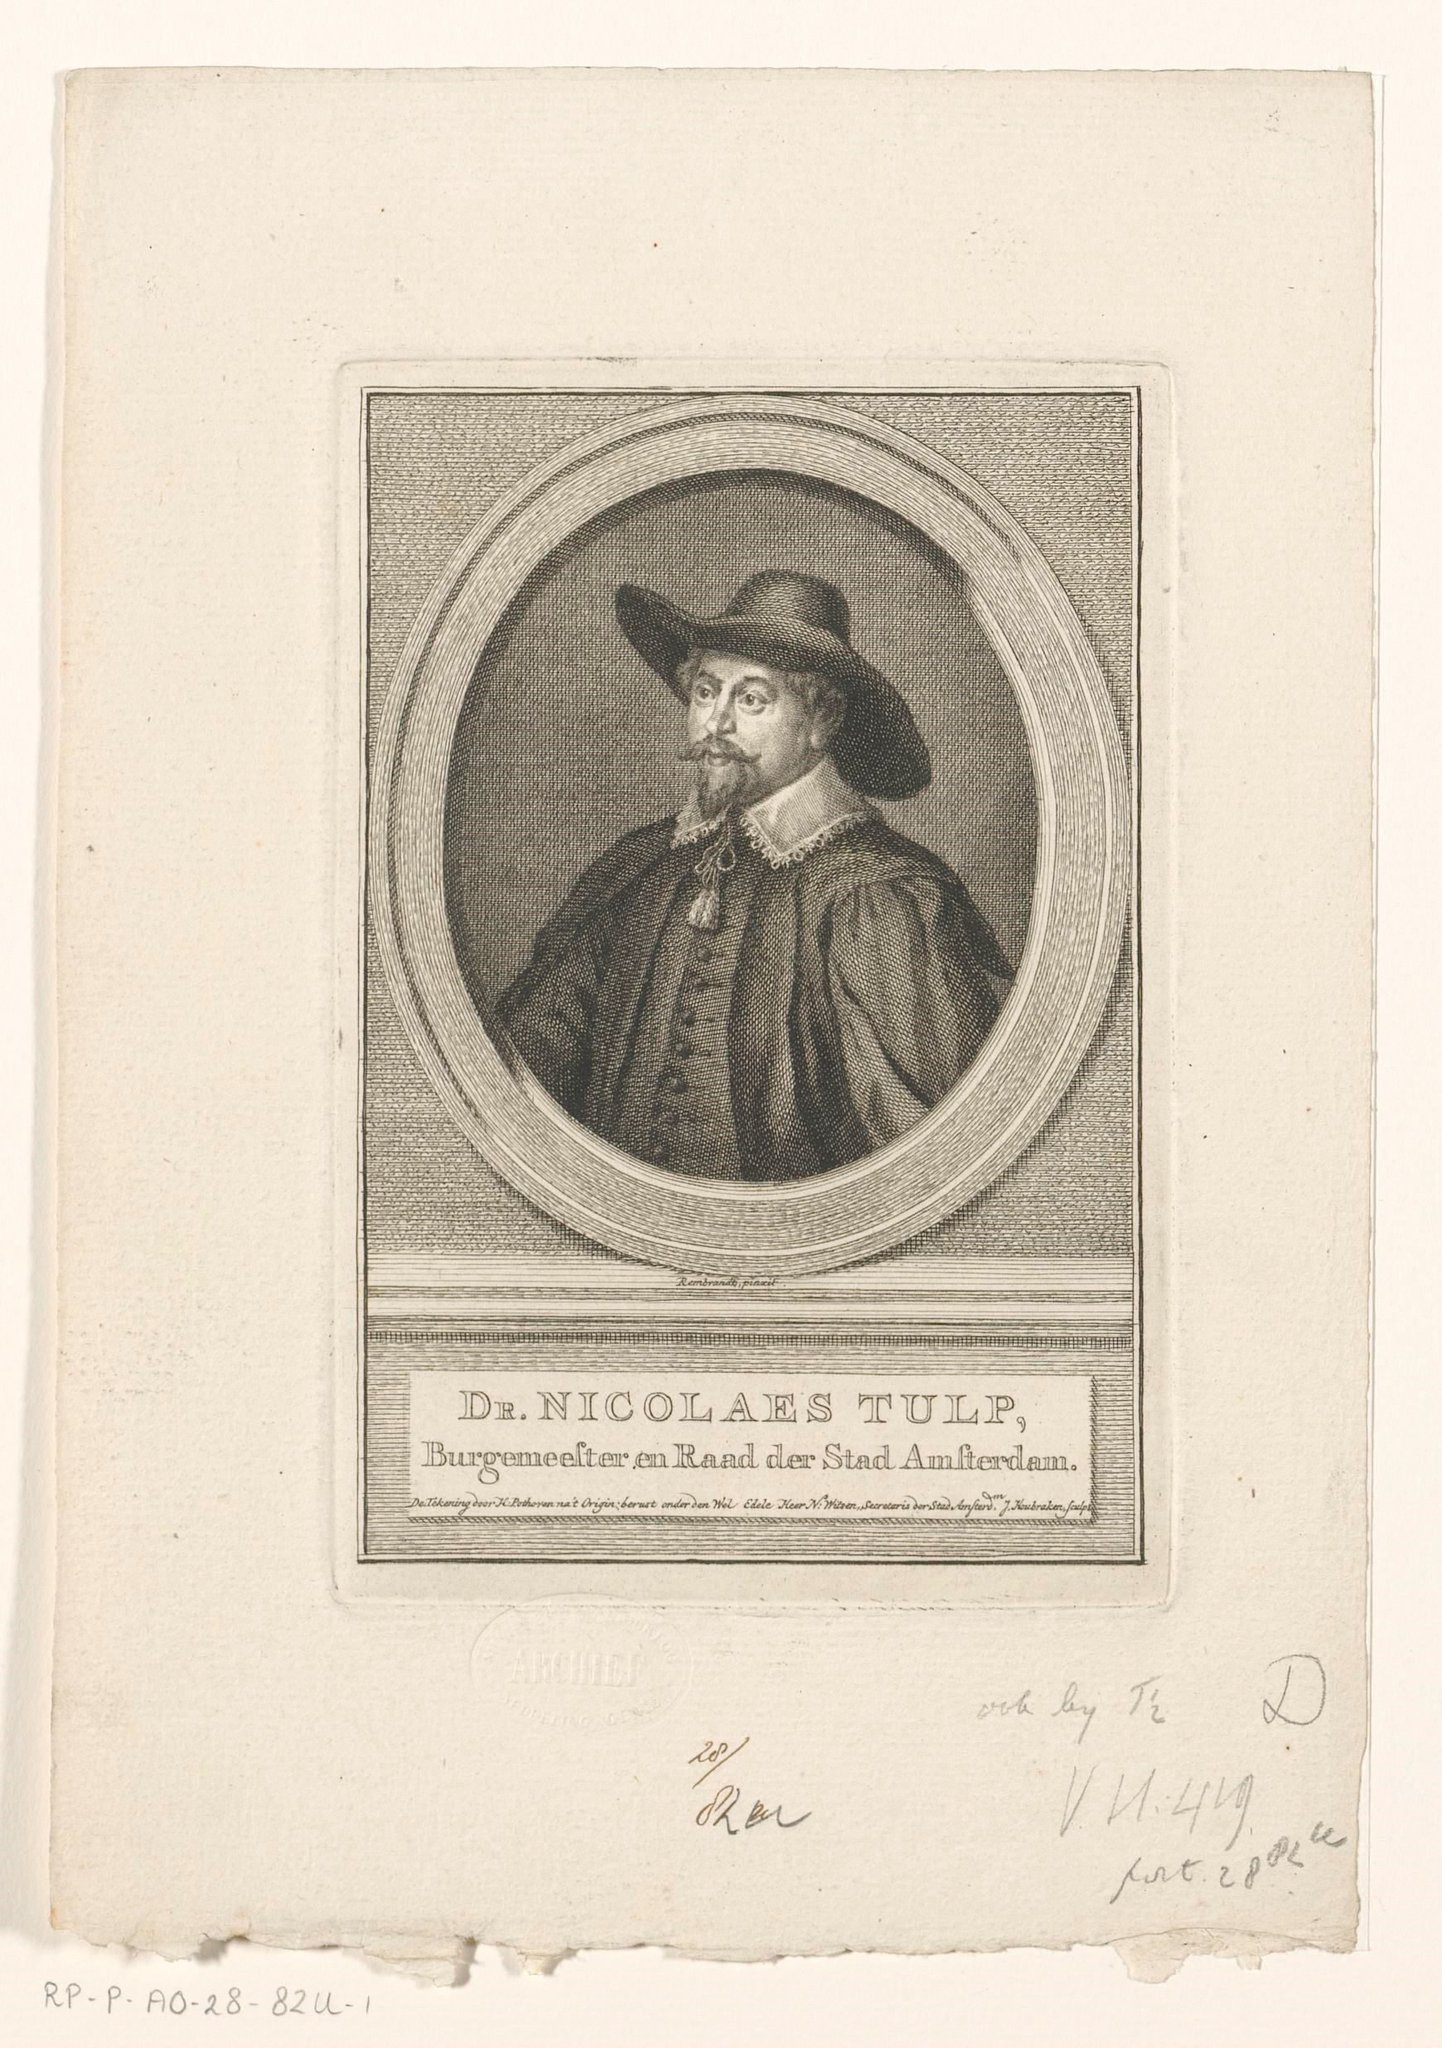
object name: print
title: Portret van Nicolaes Tulp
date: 1749-1780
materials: paper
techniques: engraving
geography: amsterdam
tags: amsterdam, the hague, mayor, historical persons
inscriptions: check stamp: ‘Archief Ministerie van Oorlog Afdeeling Genie’, collector's mark: Lugt 2228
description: Deze prent is oorspronkelijk bedoeld als aanvulling op Jan Wagenaars ‘Vaderlandsche historie’* en was zo vanaf 1796 verkrijgbaar bij Johannes Allart te Amsterdam. Voor de advertentie waarin Allart de 60 portretten en 7 platen, allen gegraveerd door Houbraken, ter aanvulling op Wagenaars ‘Vaderlandsche historie’ aanbiedt, zie RP-P-OB-77.766. *Van dit werk zijn in de achttiende eeuw meerdere uitgaves verschenen, zoals: Wagenaar, Jan. Vaderlandsche historie, vervattende de geschiedenissen der Vereenigde Nederlanden (…). 21 delen. Amsterdam: Isaak Tirion, 1749-1759. Wagenaar, Jan. Vaderlandsche historie, vervattende de geschiedenissen der nu Vereenigde Nederlanden (…). 21 delen. Amsterdam: weduwe Isaak Tirion, 1770. Wagenaar, Jan. Vaderlandsche historie, vervattende de geschiedenissen der nu Vereenigde Nederlanden (…). 21 delen. Amsterdam, Leiden, Dordrecht en Harlingen: P. Schouten e.a., 1782. Wagenaar, Jan. Vaderlandsche historie, vervattende de geschiedenissen der nu Vereenigde Nederlanden (…). 21 delen. Amsterdam: Johannes Allart, 1790-1796.